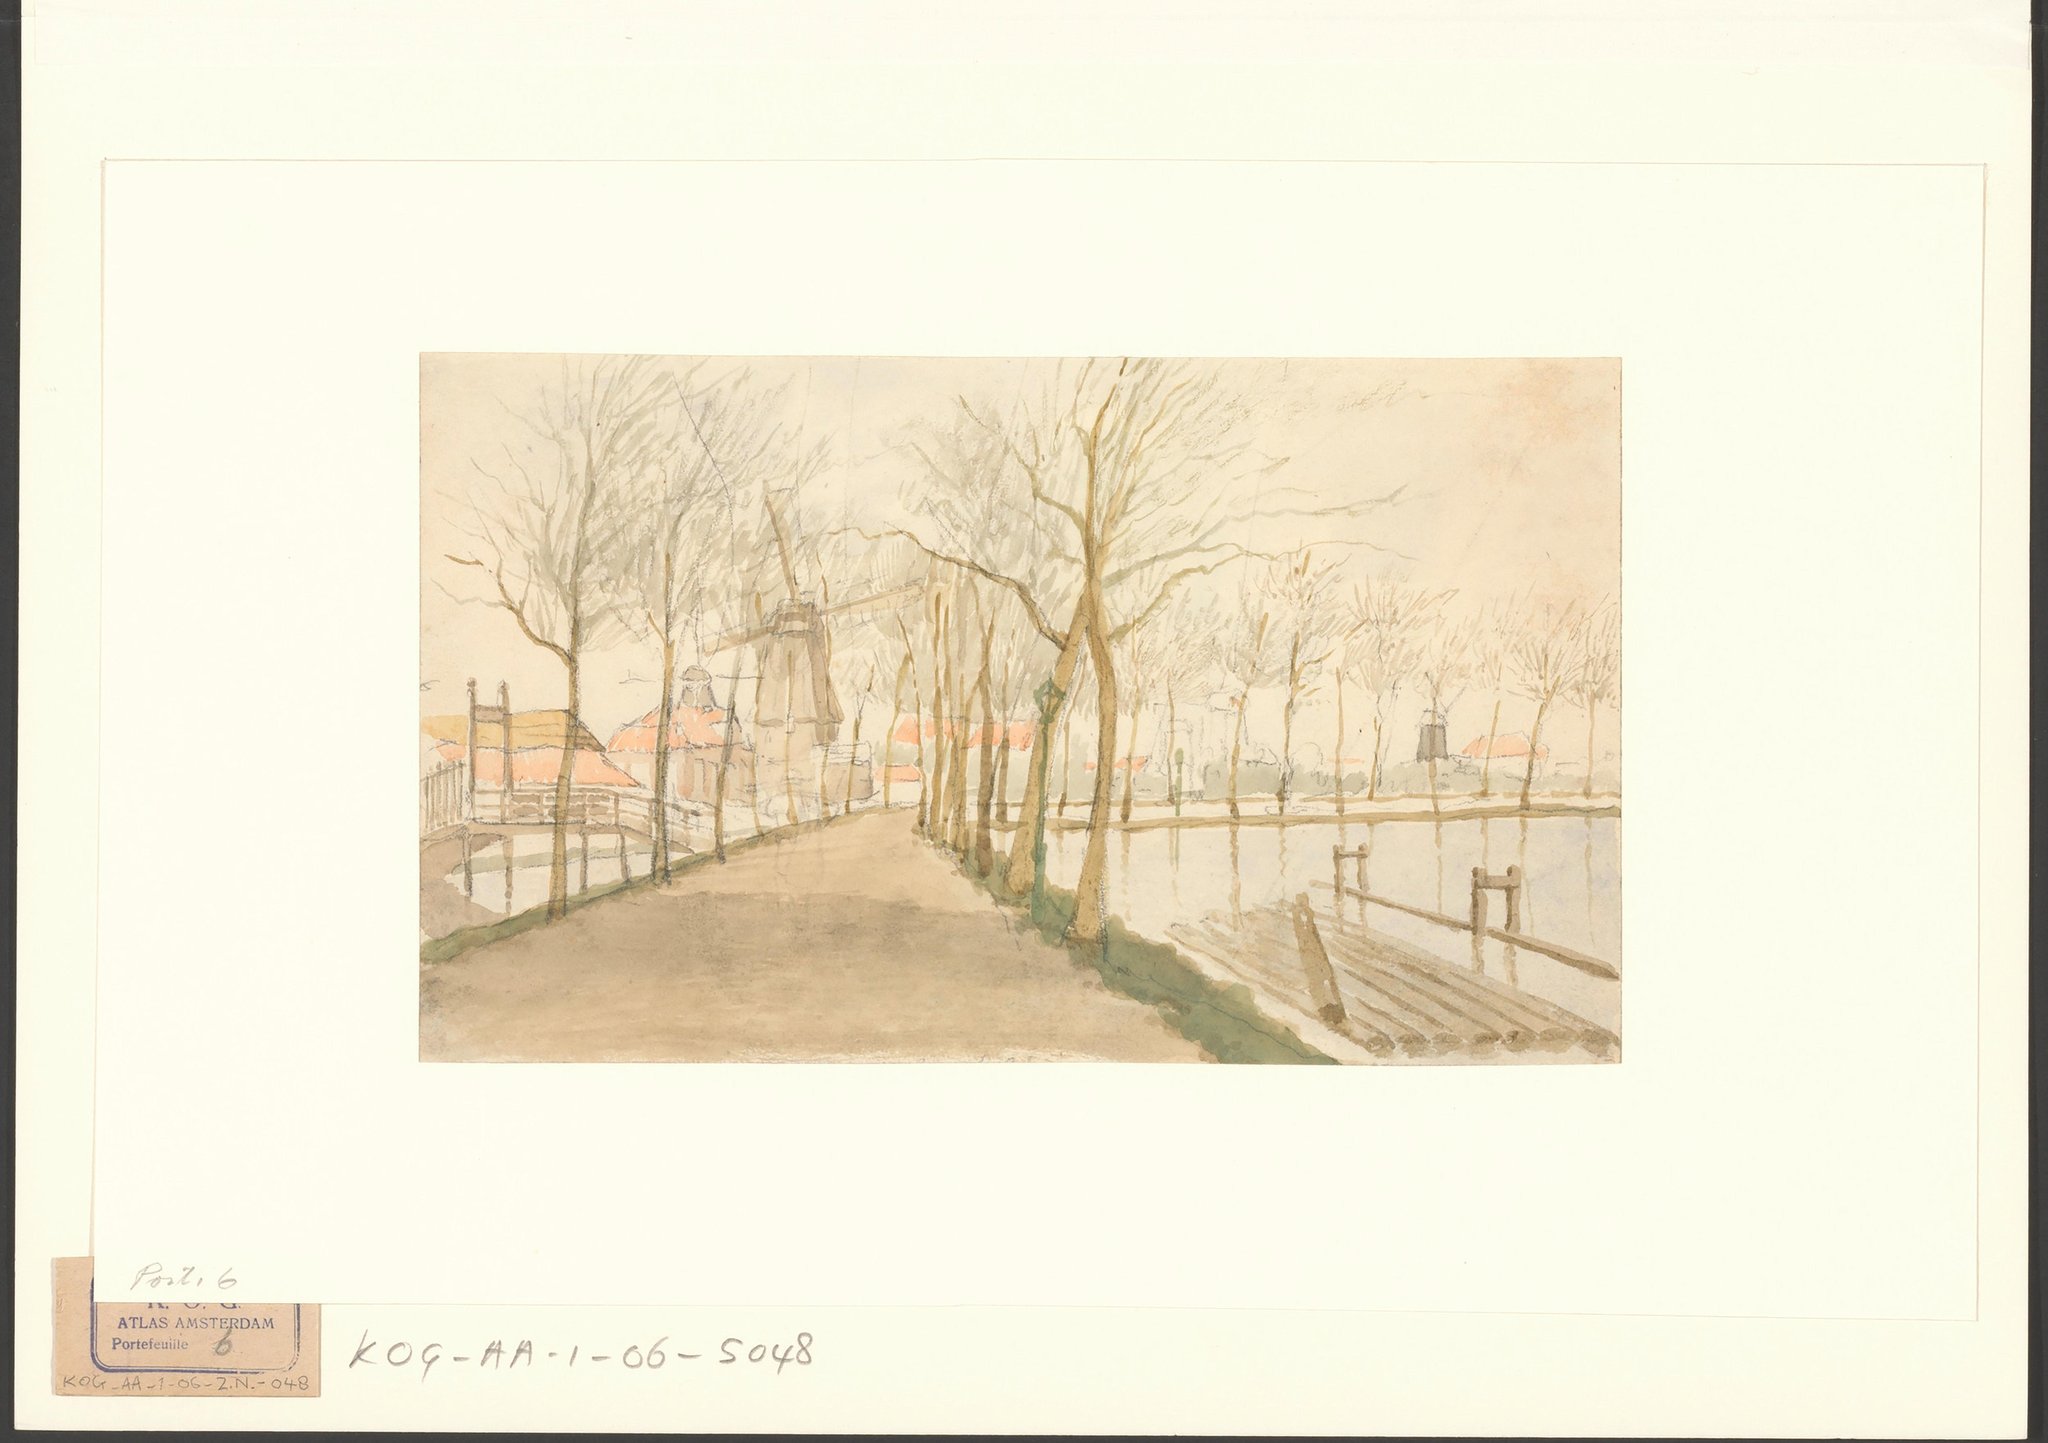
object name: drawing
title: Gezicht op het Singel tussen de Raampoort en de Zaagmolenpoort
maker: johan martinus anthon rieke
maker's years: 1851-1899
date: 1881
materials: chalk, paper, watercolor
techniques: brush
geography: amsterdam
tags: city-view in general; 'veduta', river, road, path, windmill in landscape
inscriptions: collector's mark: ‘6’ Lugt 1641b, signature, date and inscription: ‘Buitensingel tusschen / Raam en Zaagpoort / ziende naar de Molens / de Jager de [...]molen / de Roo Koe. 1881 J M A Rieke’, inscription: ‘Port. 6’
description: Onderwerpsrubriek binnen de Atlas Amsterdam: Buitensingel, Gezichten langs en op de Stadsvest van Haarlemmerpoort tot Raampoort.